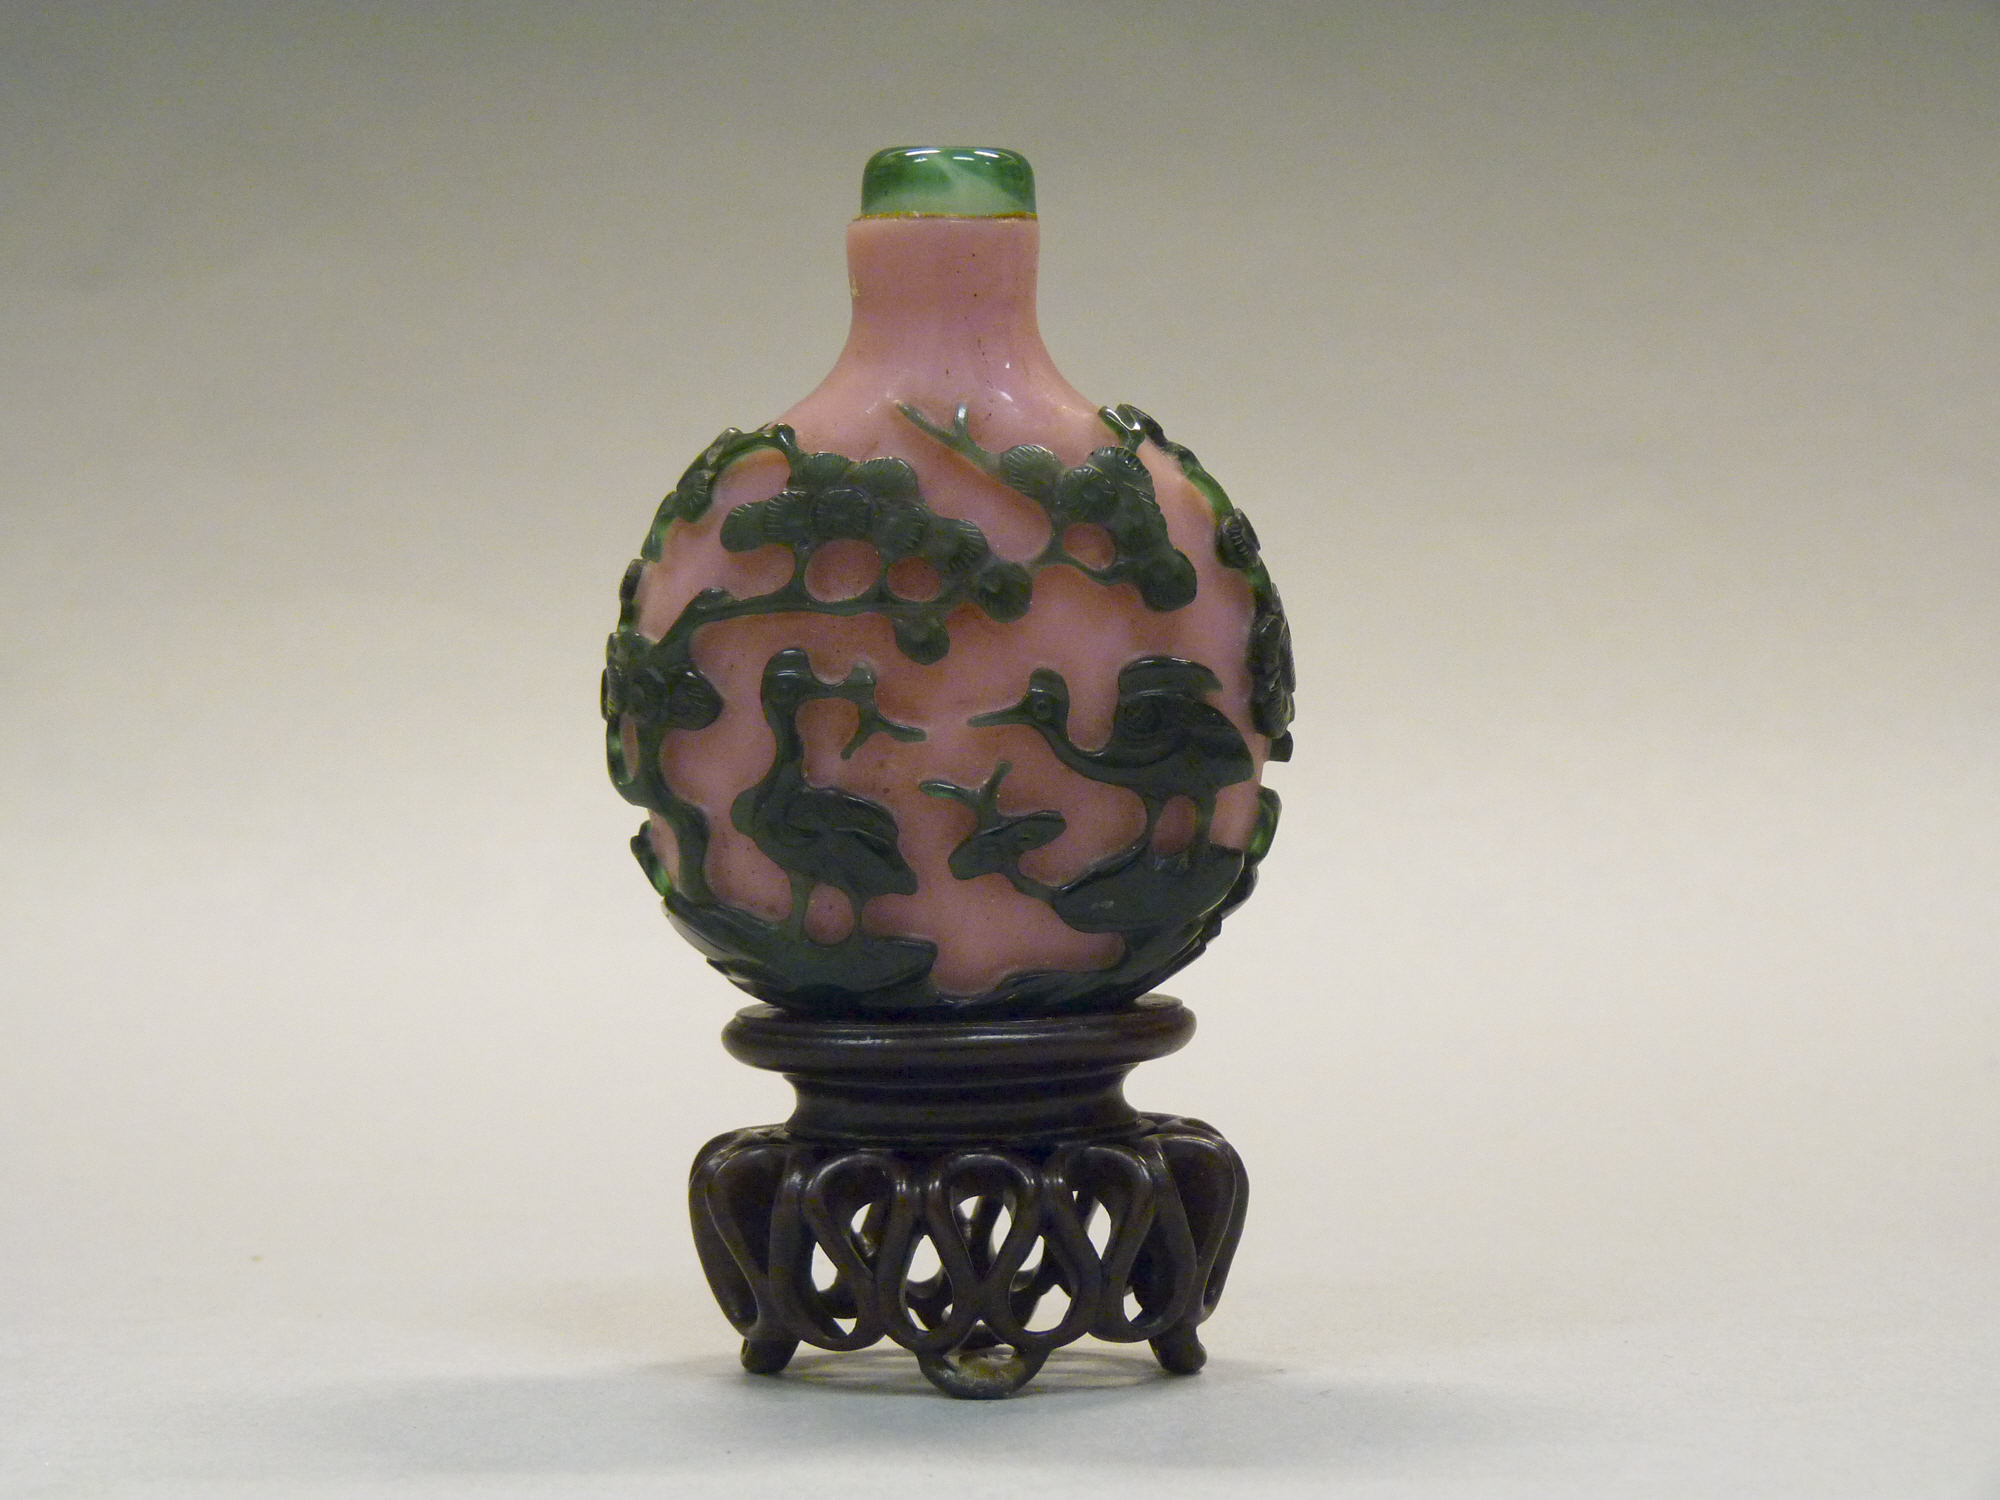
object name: snuff bottle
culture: chinese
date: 1736-1795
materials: glass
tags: birds